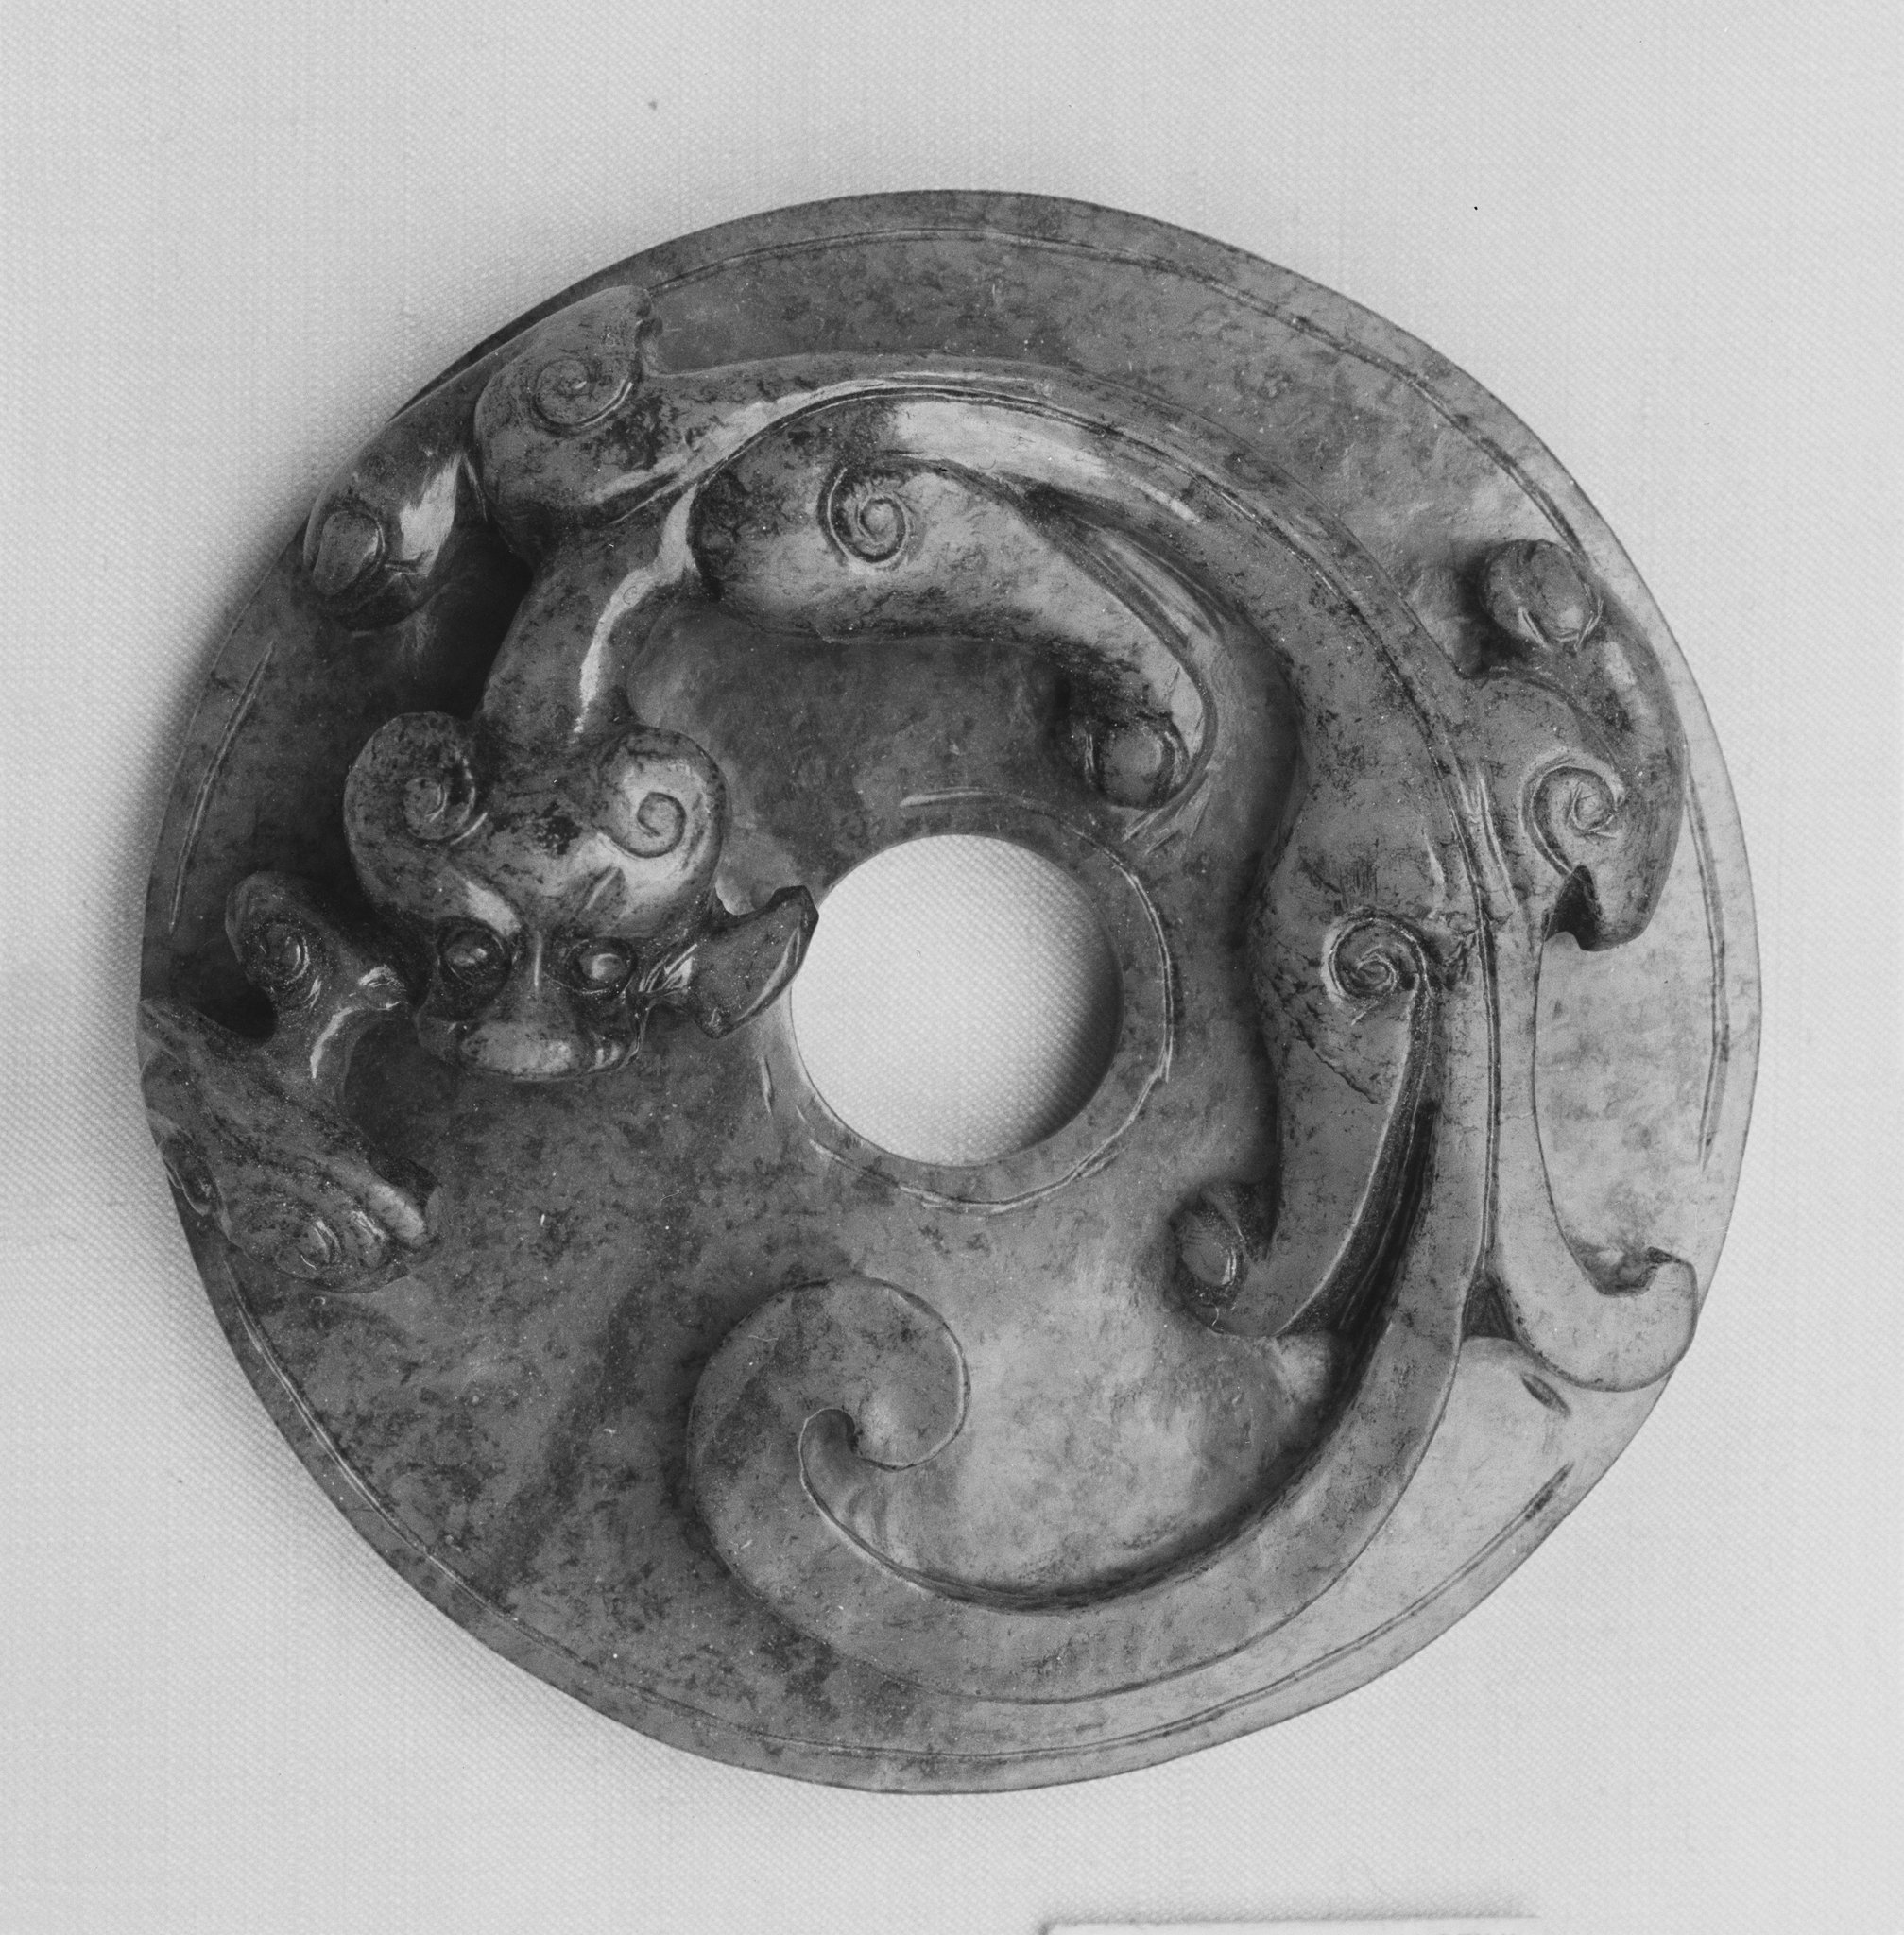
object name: disk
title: Disk with dragon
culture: chinese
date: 1867-1933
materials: jade